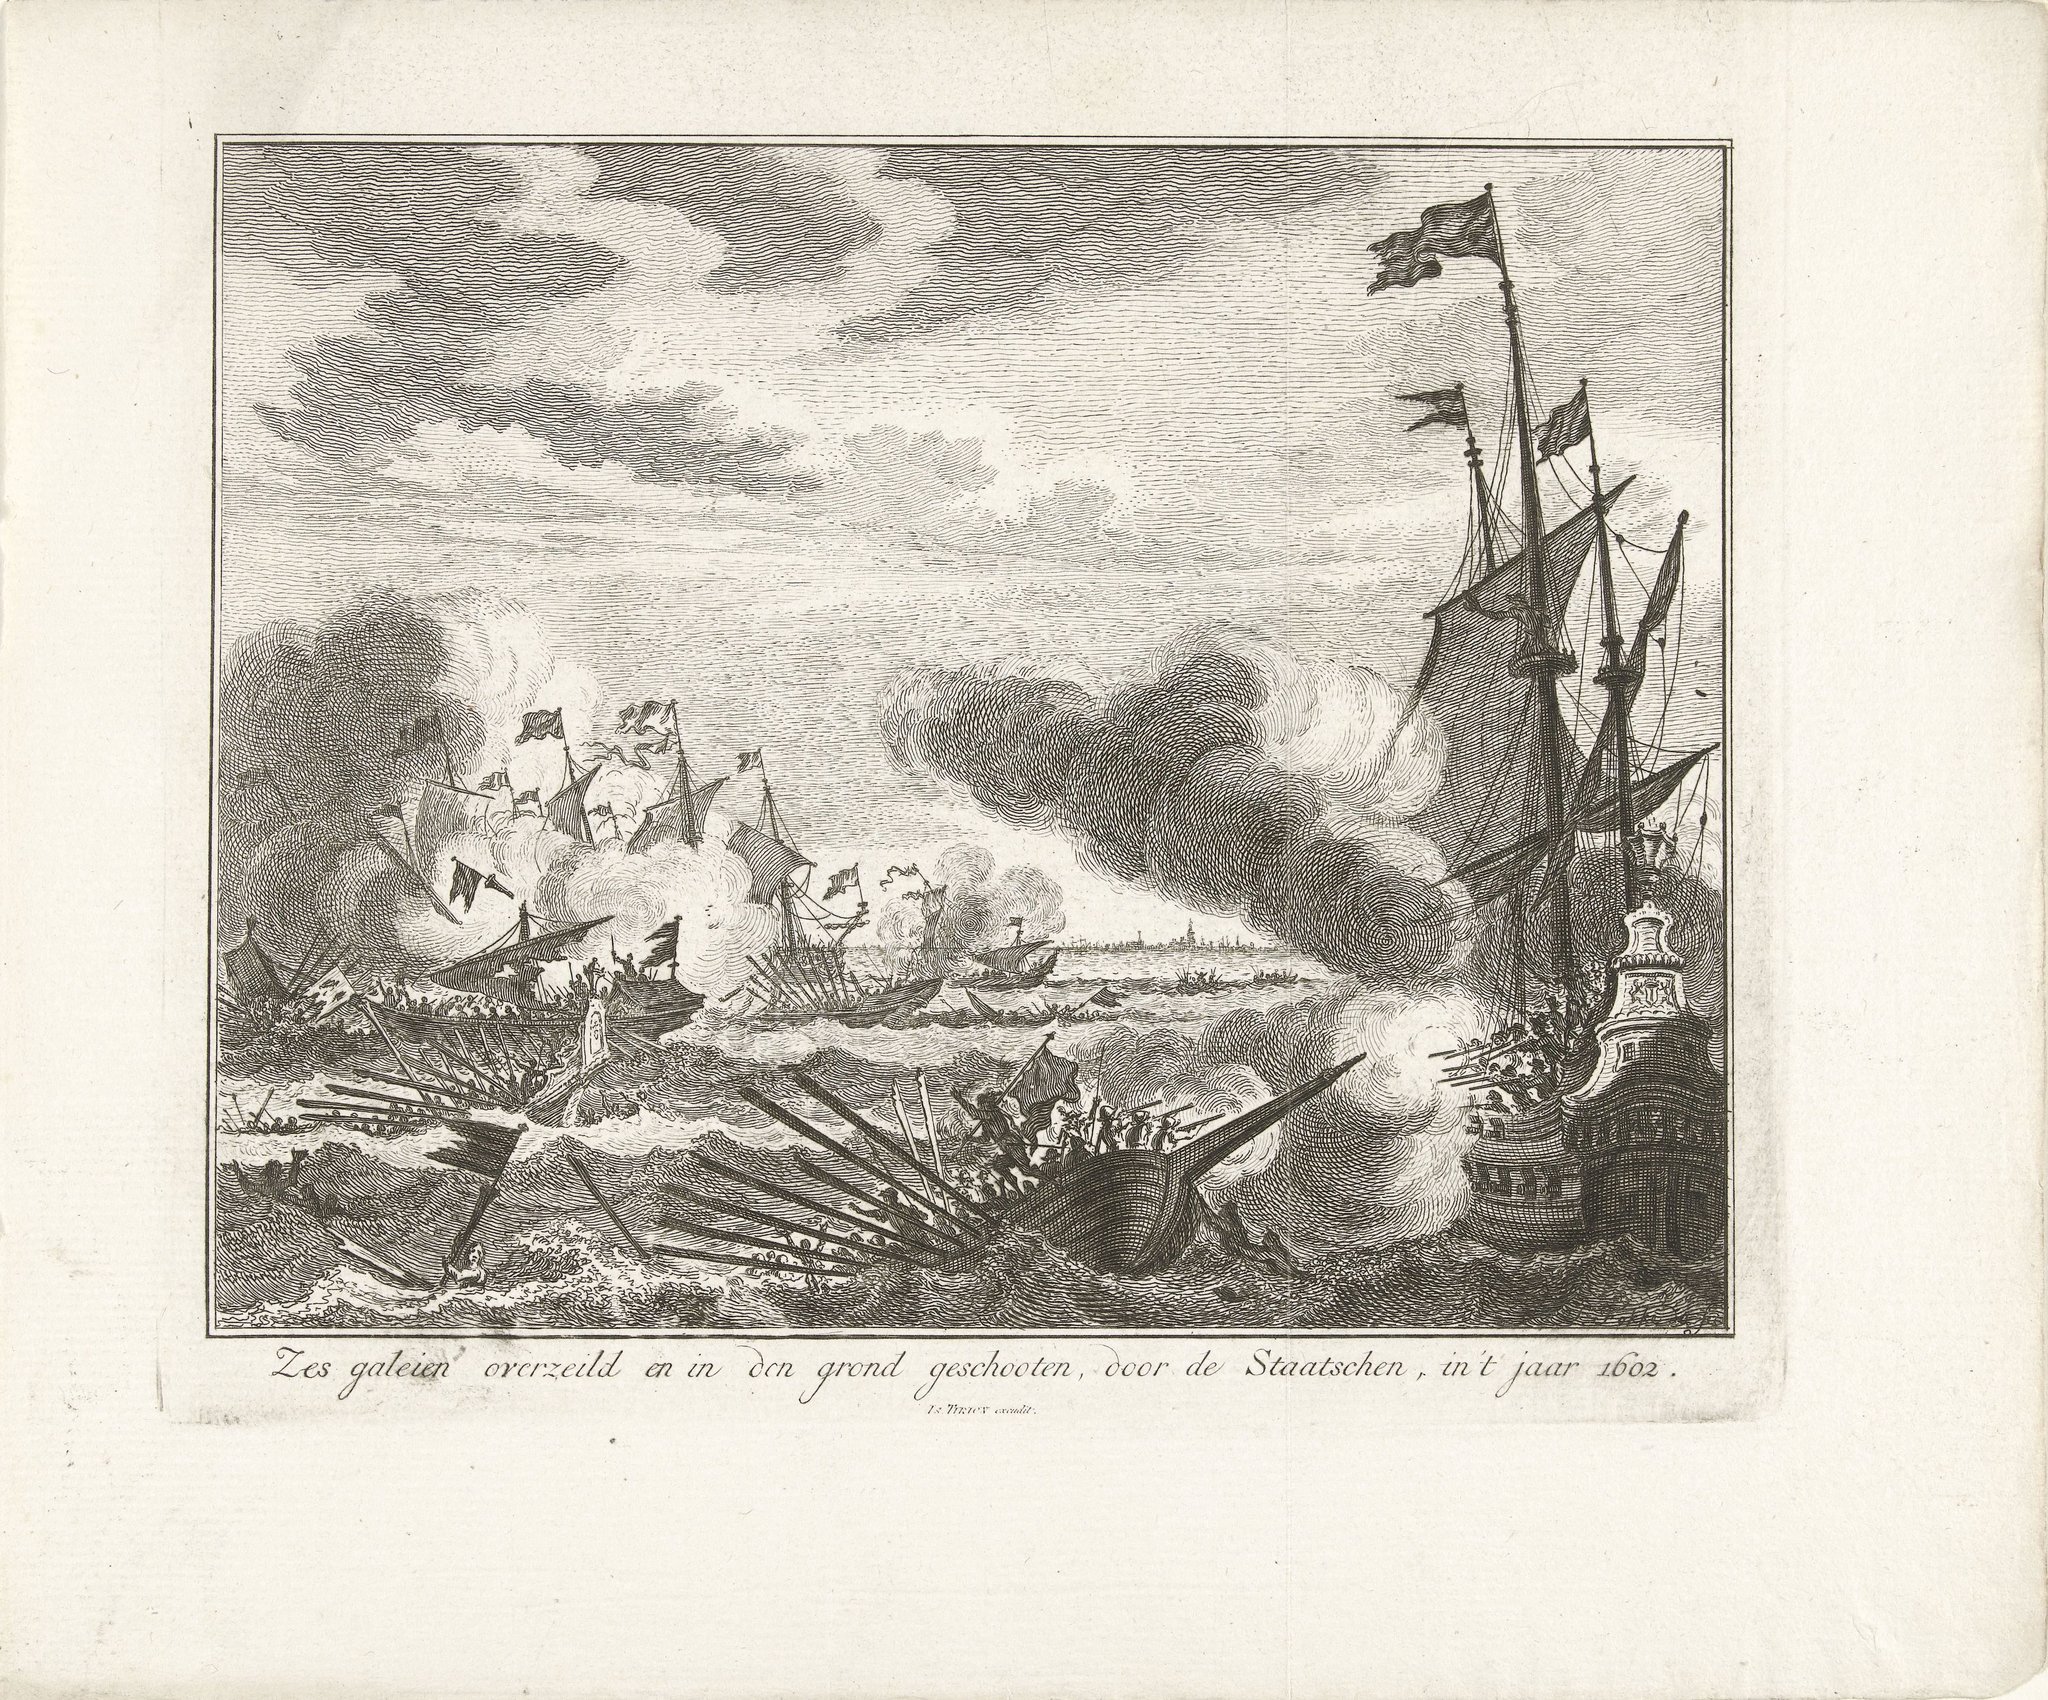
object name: print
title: Zeeslag met de zes Spaanse galeien van Spinola, 1602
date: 1729-1766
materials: paper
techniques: etching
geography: amsterdam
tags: battle (+ naval force), warfare; military affairs (+ oared ships, e.g.: galley), english channel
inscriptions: collector's mark: Lugt 2228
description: Zeeslag waarbij de zes Spaanse galeien van Ambrogio Spinola in het Kanaal worden verslagen door de Staatse vloot.